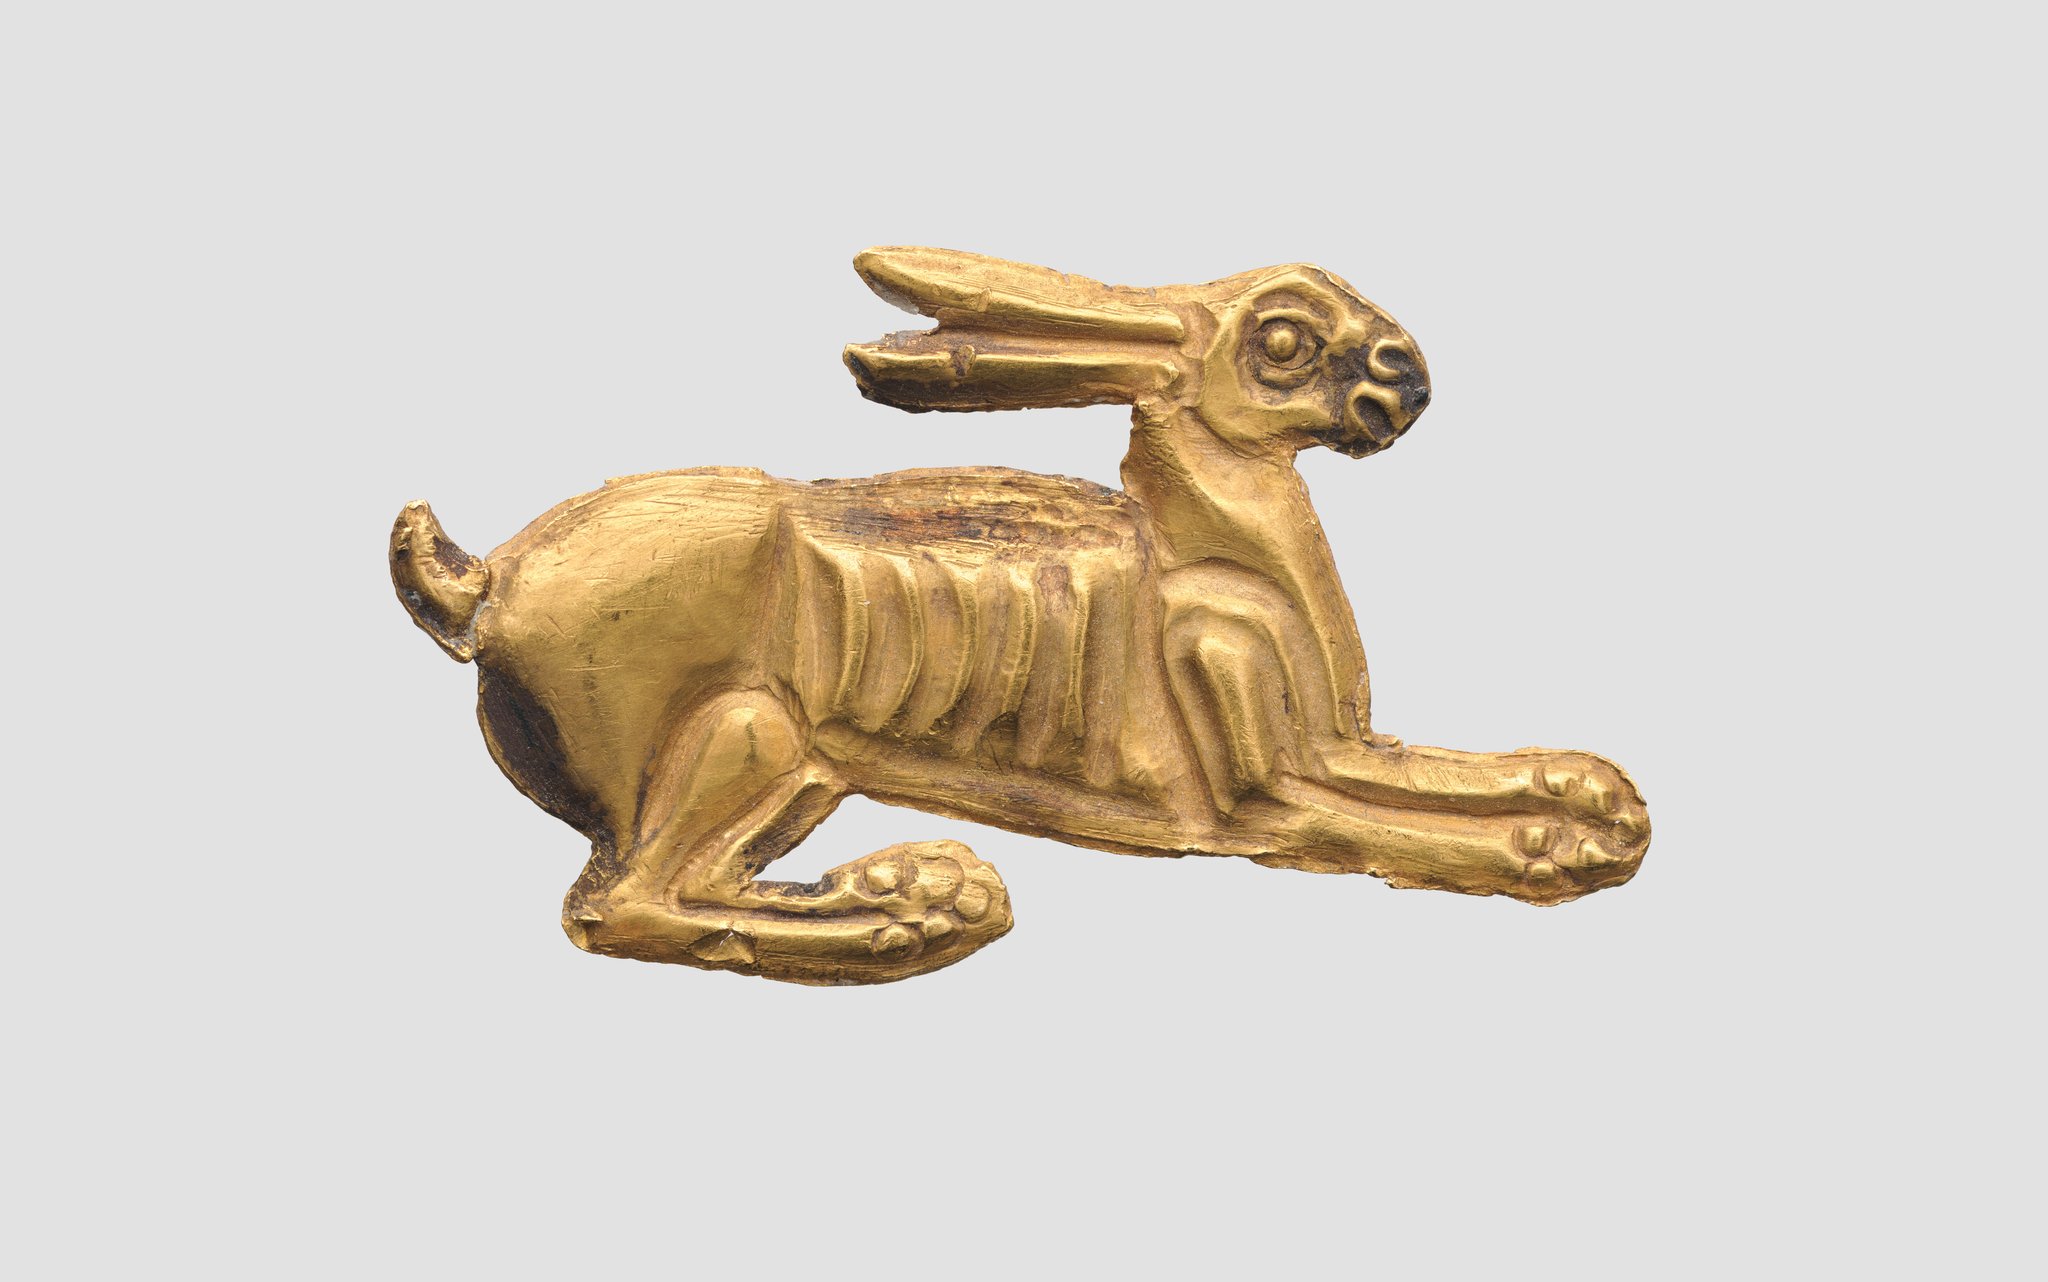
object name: inlay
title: Inlay for a plate in the form of a hare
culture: scythian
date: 700-601 BCE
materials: gold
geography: iran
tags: animals